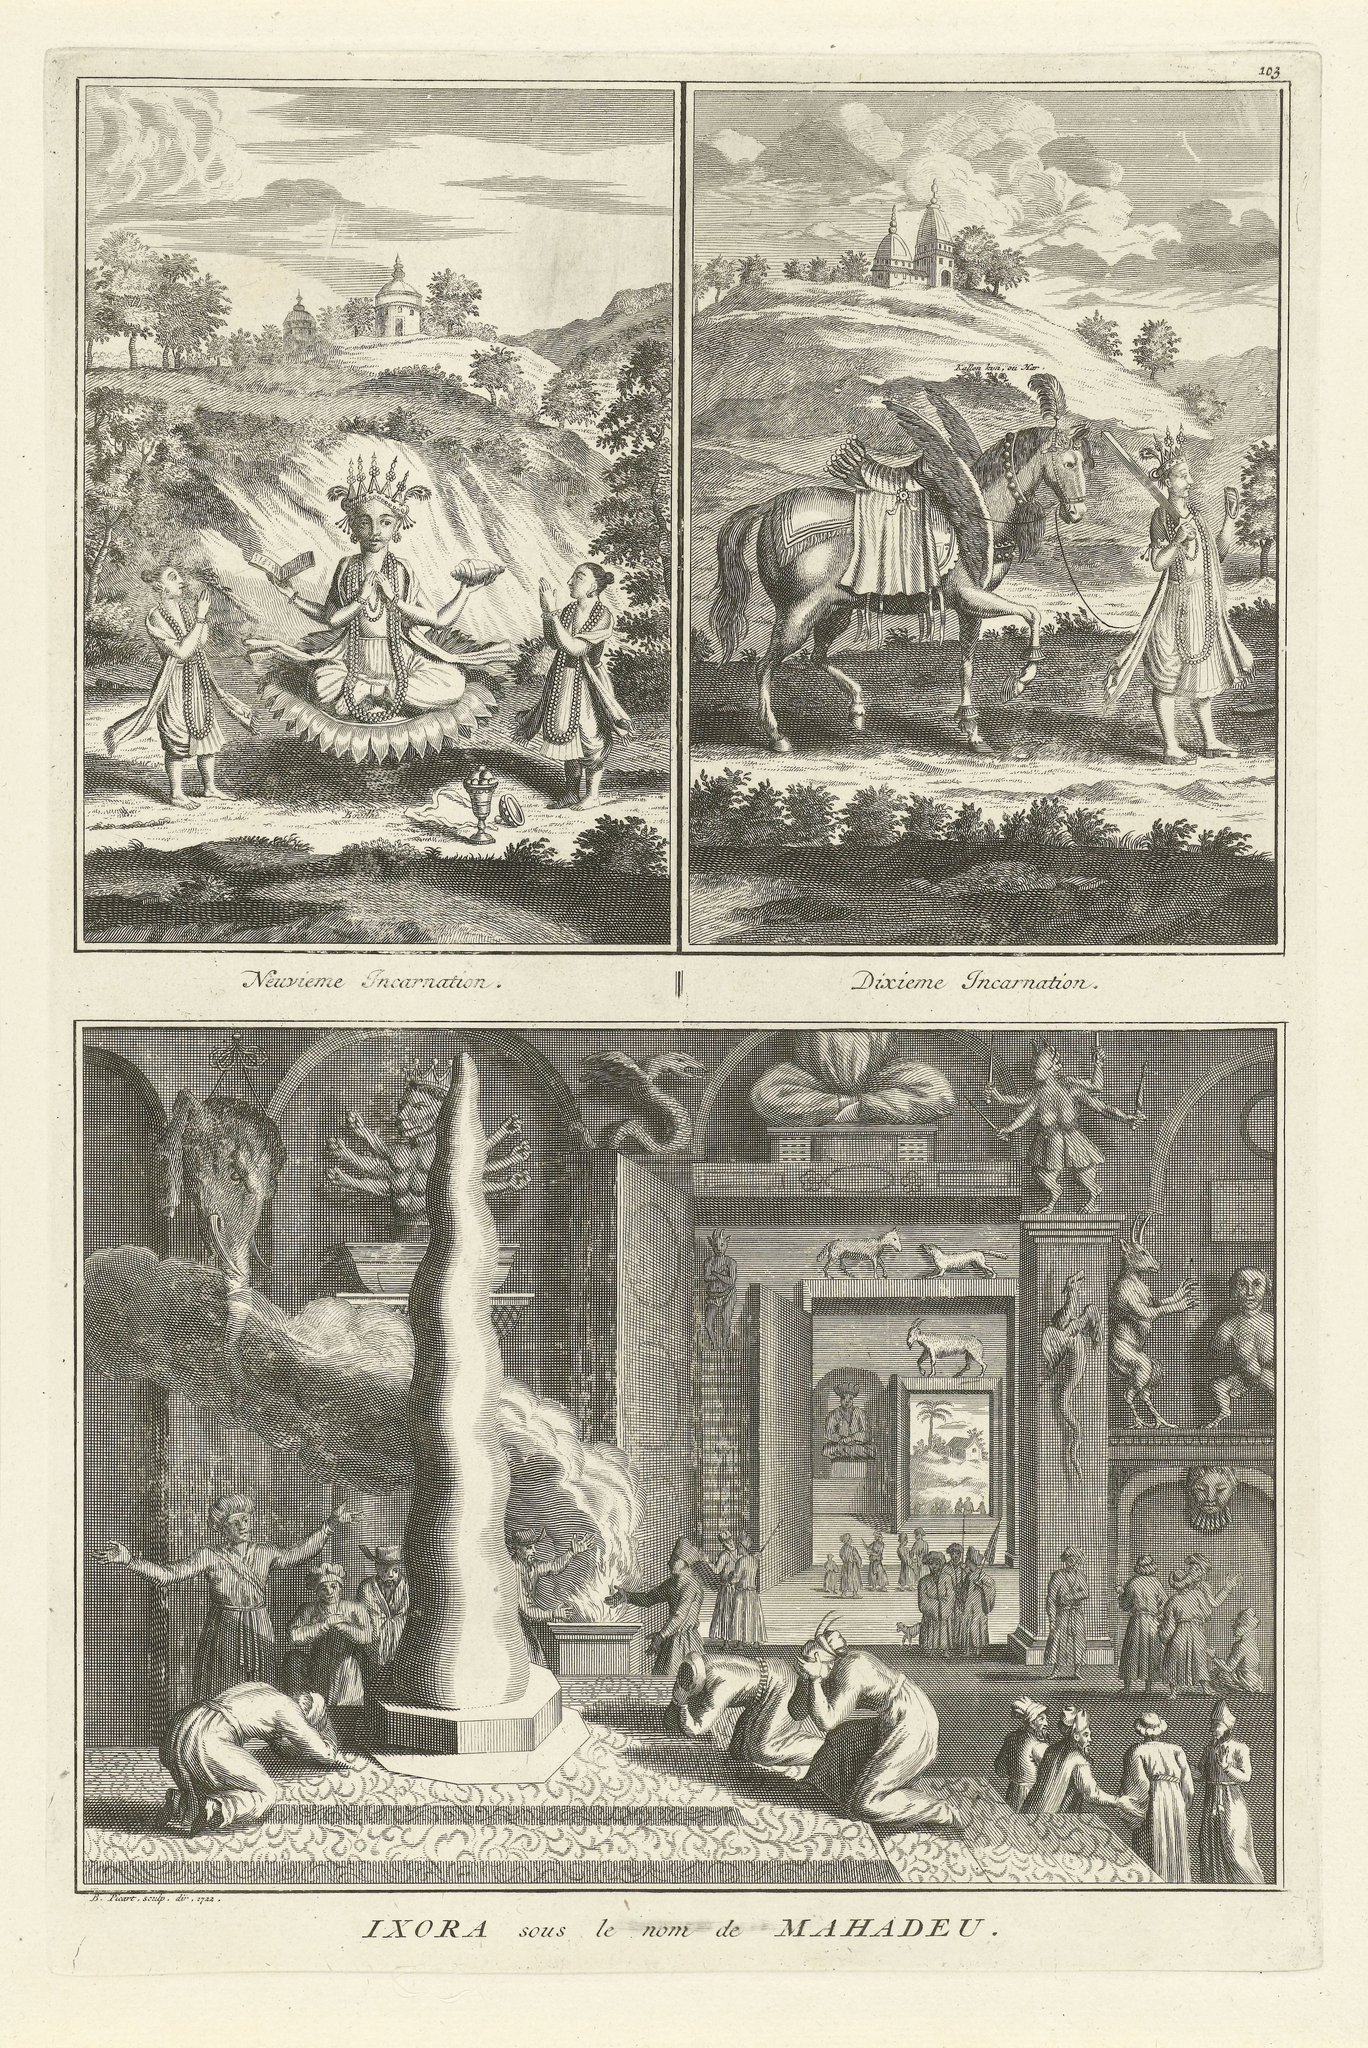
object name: print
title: Voorstellingen van de incarnaties van de Indiase god Vishnu en verering van Ixora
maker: bernard picart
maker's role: draughtsman, print maker, publisher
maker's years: 1673-1733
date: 1722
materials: paper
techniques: engraving, etching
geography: amsterdam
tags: ritual practices ~ hinduism, buddhism, jainism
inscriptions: collector's mark: Lugt 2228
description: Blad met twee voorstellingen van incarnaties uit het hindoeïsme en de verering van Ixora. Boven: De Indiase god Vishnu komt tien keer op aarde, in tien verschillende gedaantes, om de wereld te redden. Hier voorgesteld respectievelijk de negende en tiende incarnatie: Boeddha en Kalki. Onder: Interieur van een tempel waar het beeld van de god Ixora in de gedaante van een pilaar wordt vereerd. Onder de voorstellingen een onderschrift in het Frans. Rechtsboven genummerd: 103.